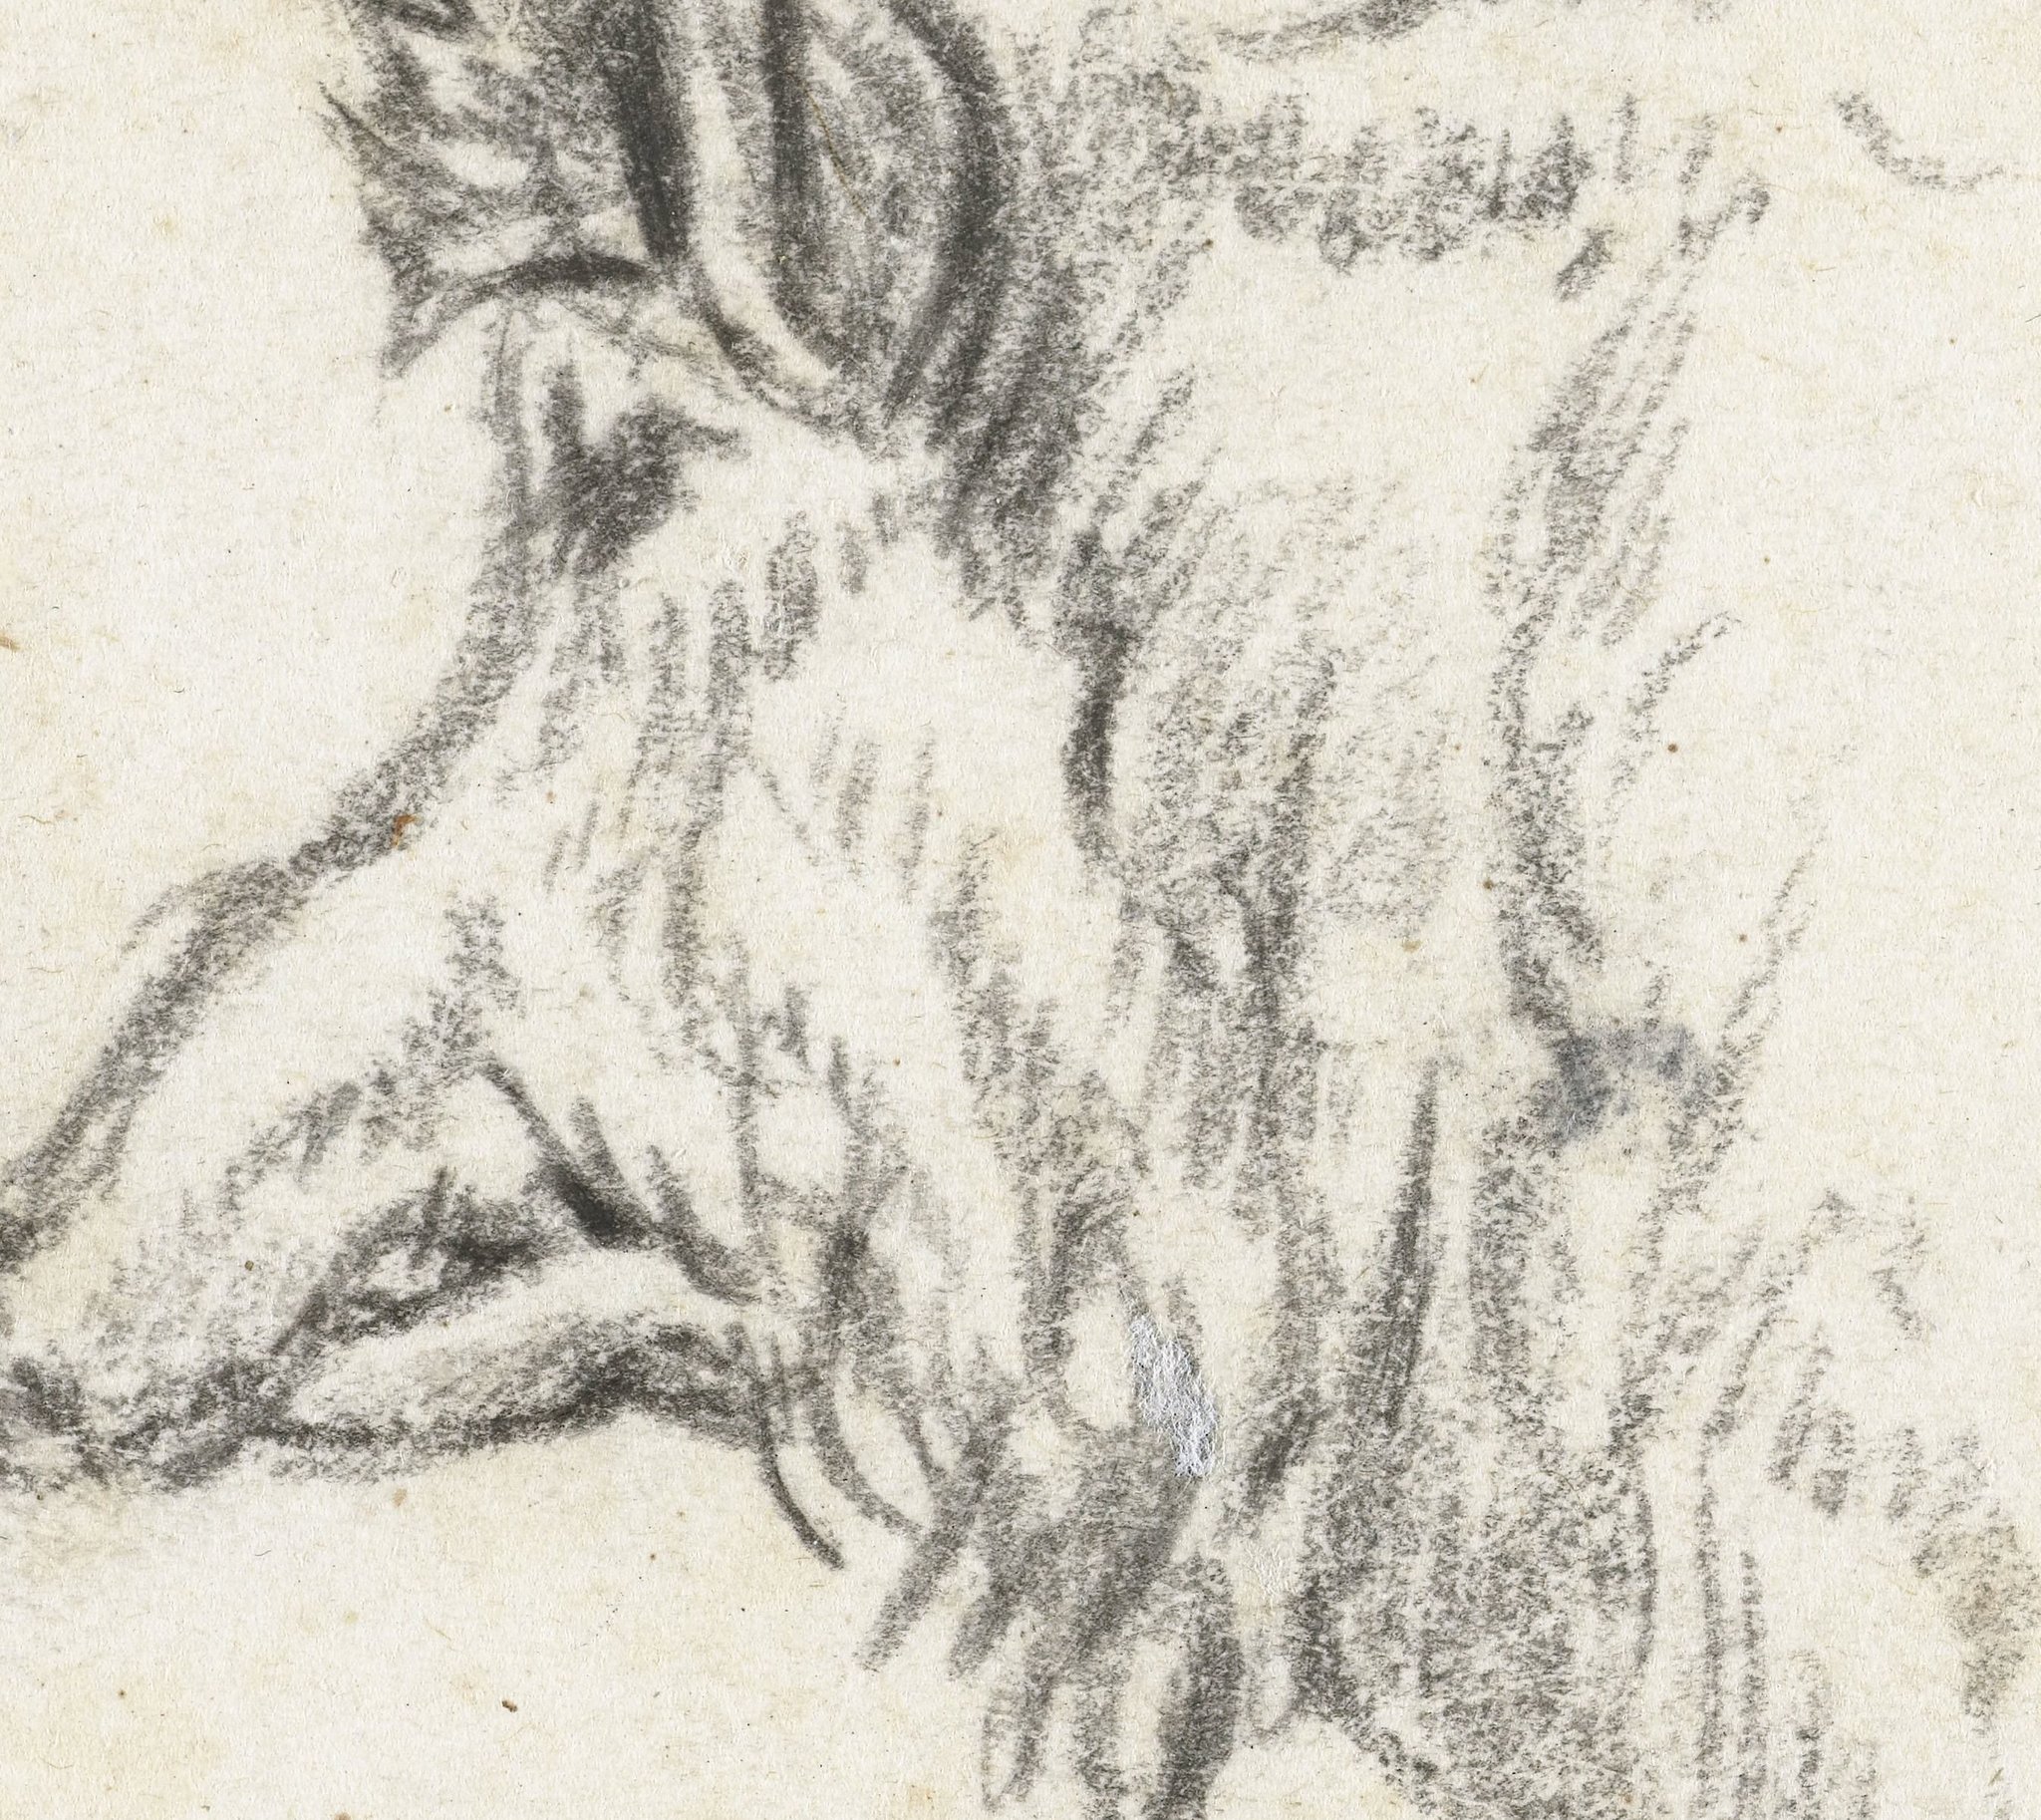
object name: drawing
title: Kop van een wild varken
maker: paulus potter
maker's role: draughtsman, painter, print maker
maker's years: 1625-1654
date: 1635-1654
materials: chalk, paper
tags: pig